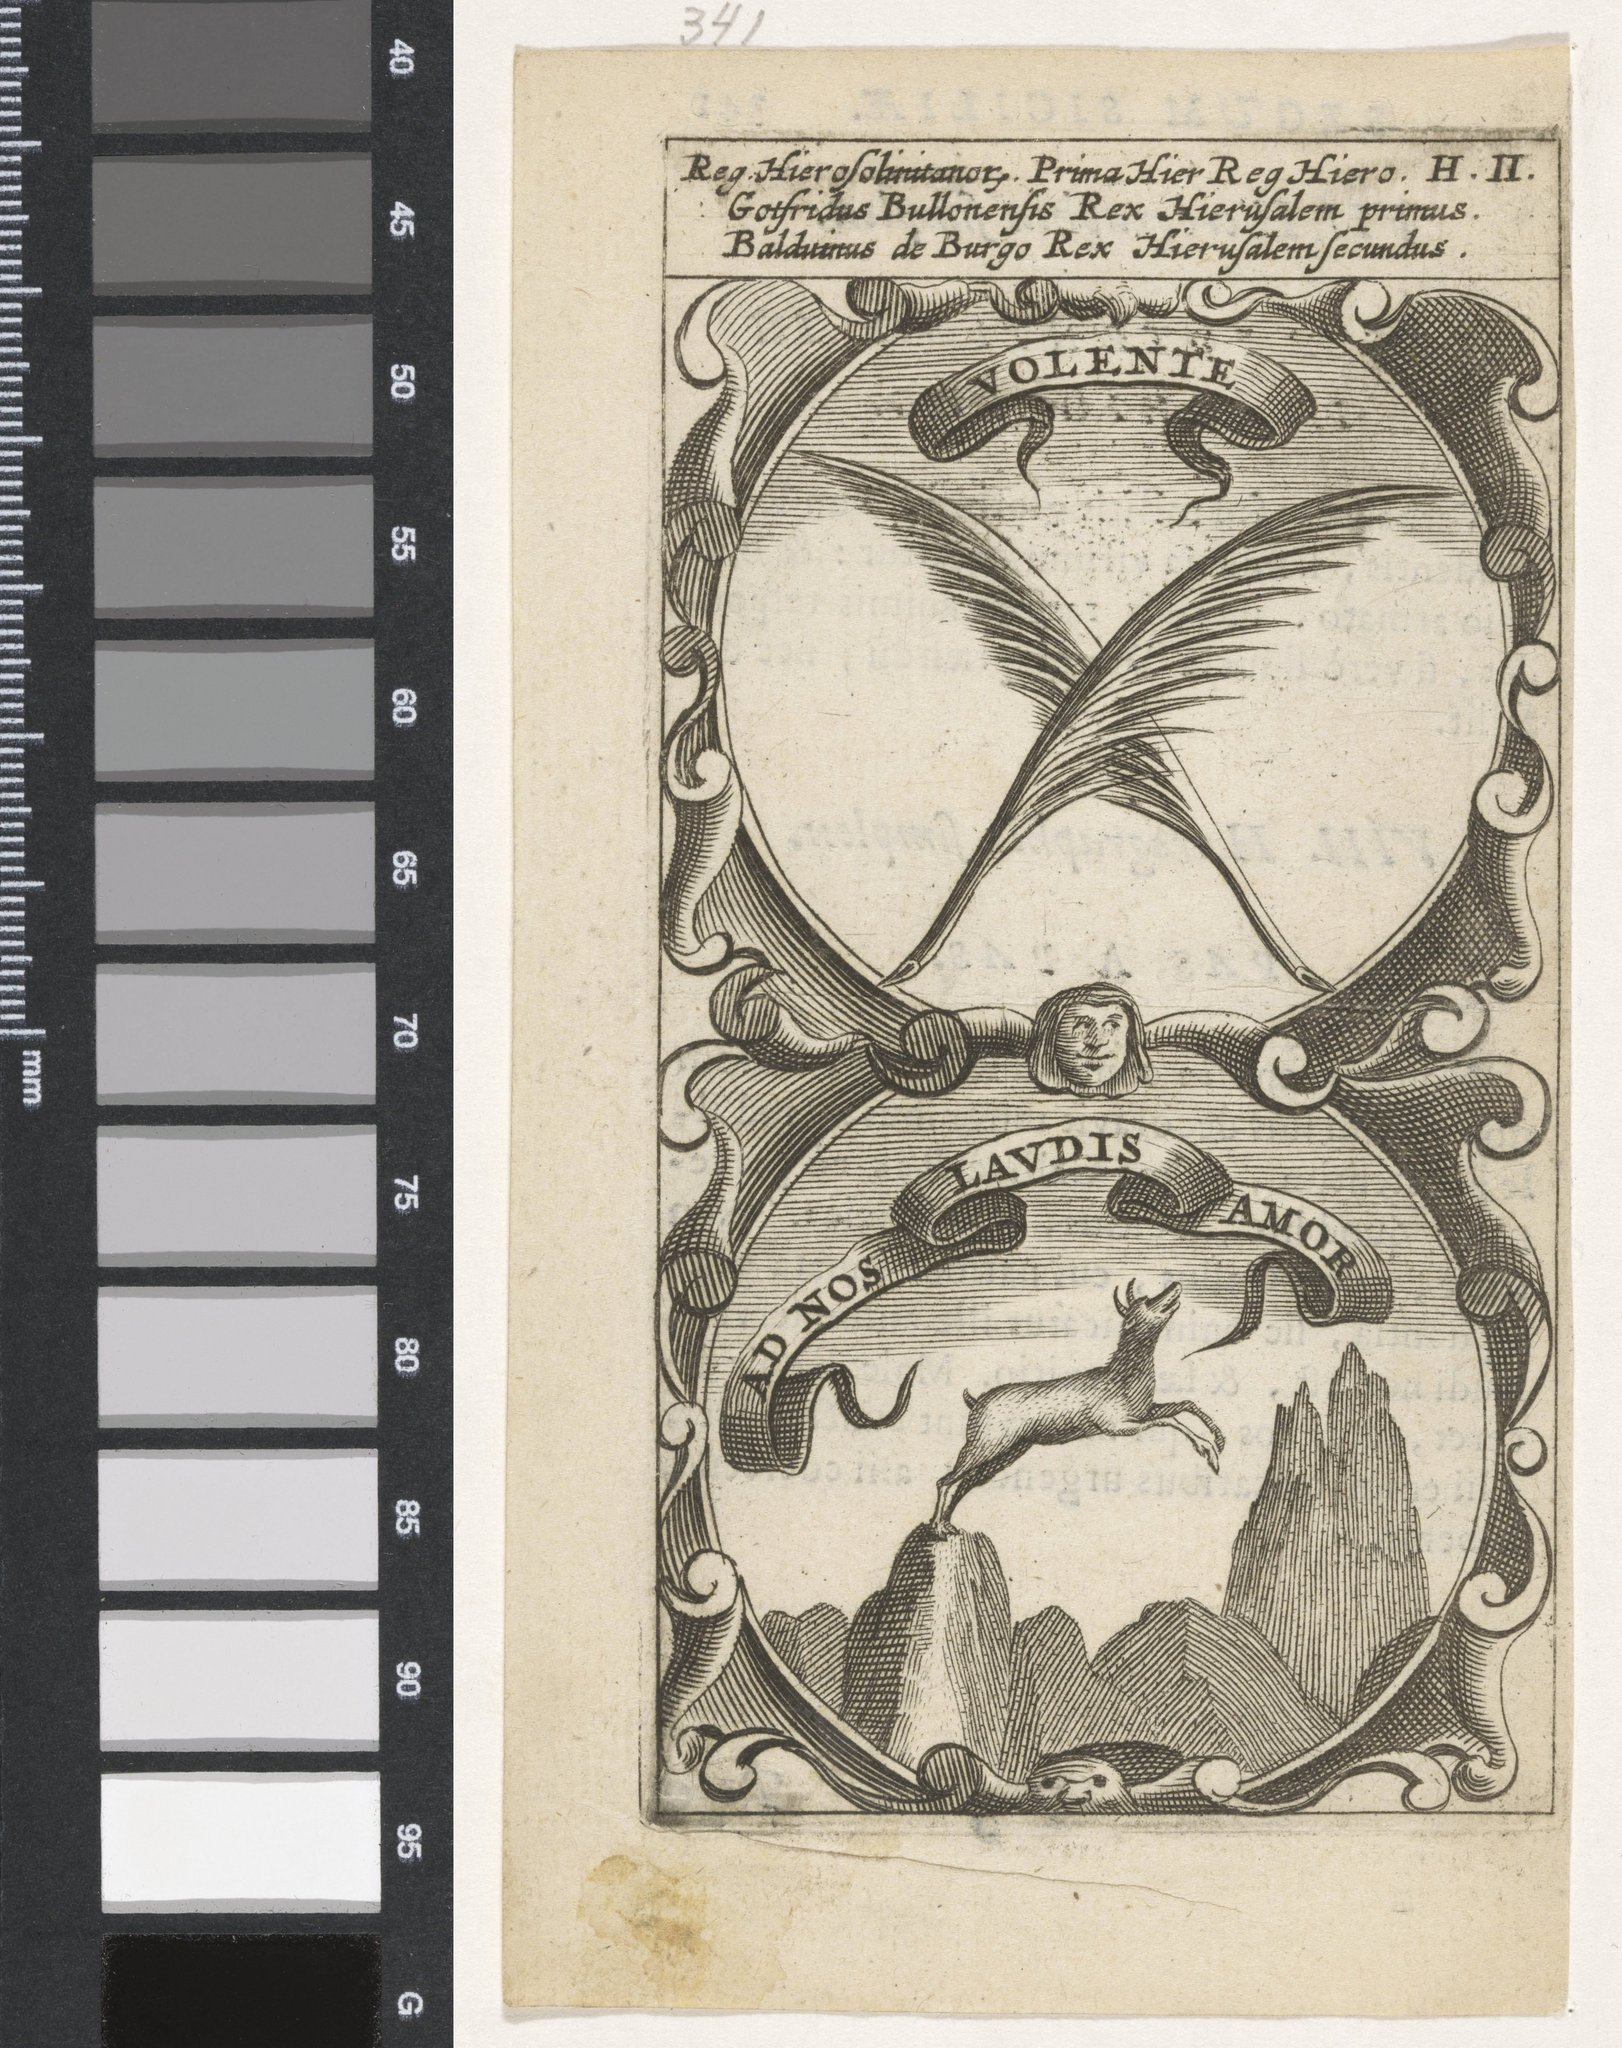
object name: print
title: Symbola Divina et Humana Pontificum Imperatorum Regum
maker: Anonymous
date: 1666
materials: paper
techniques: engraving, letterpress printing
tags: godfrey of bouillon, goat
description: Pagina uit Jacob Typotius, Symbola Divina & Humana Pontificum Imperatorum Regum. Arnhem, J.F. Hagen, 1666 of uit de titeluitgave van 1669 of 1679. Het werk van Typotius werd voor het eerst uitgegeven in 1601 met prenten van Aegidius Sadeler.